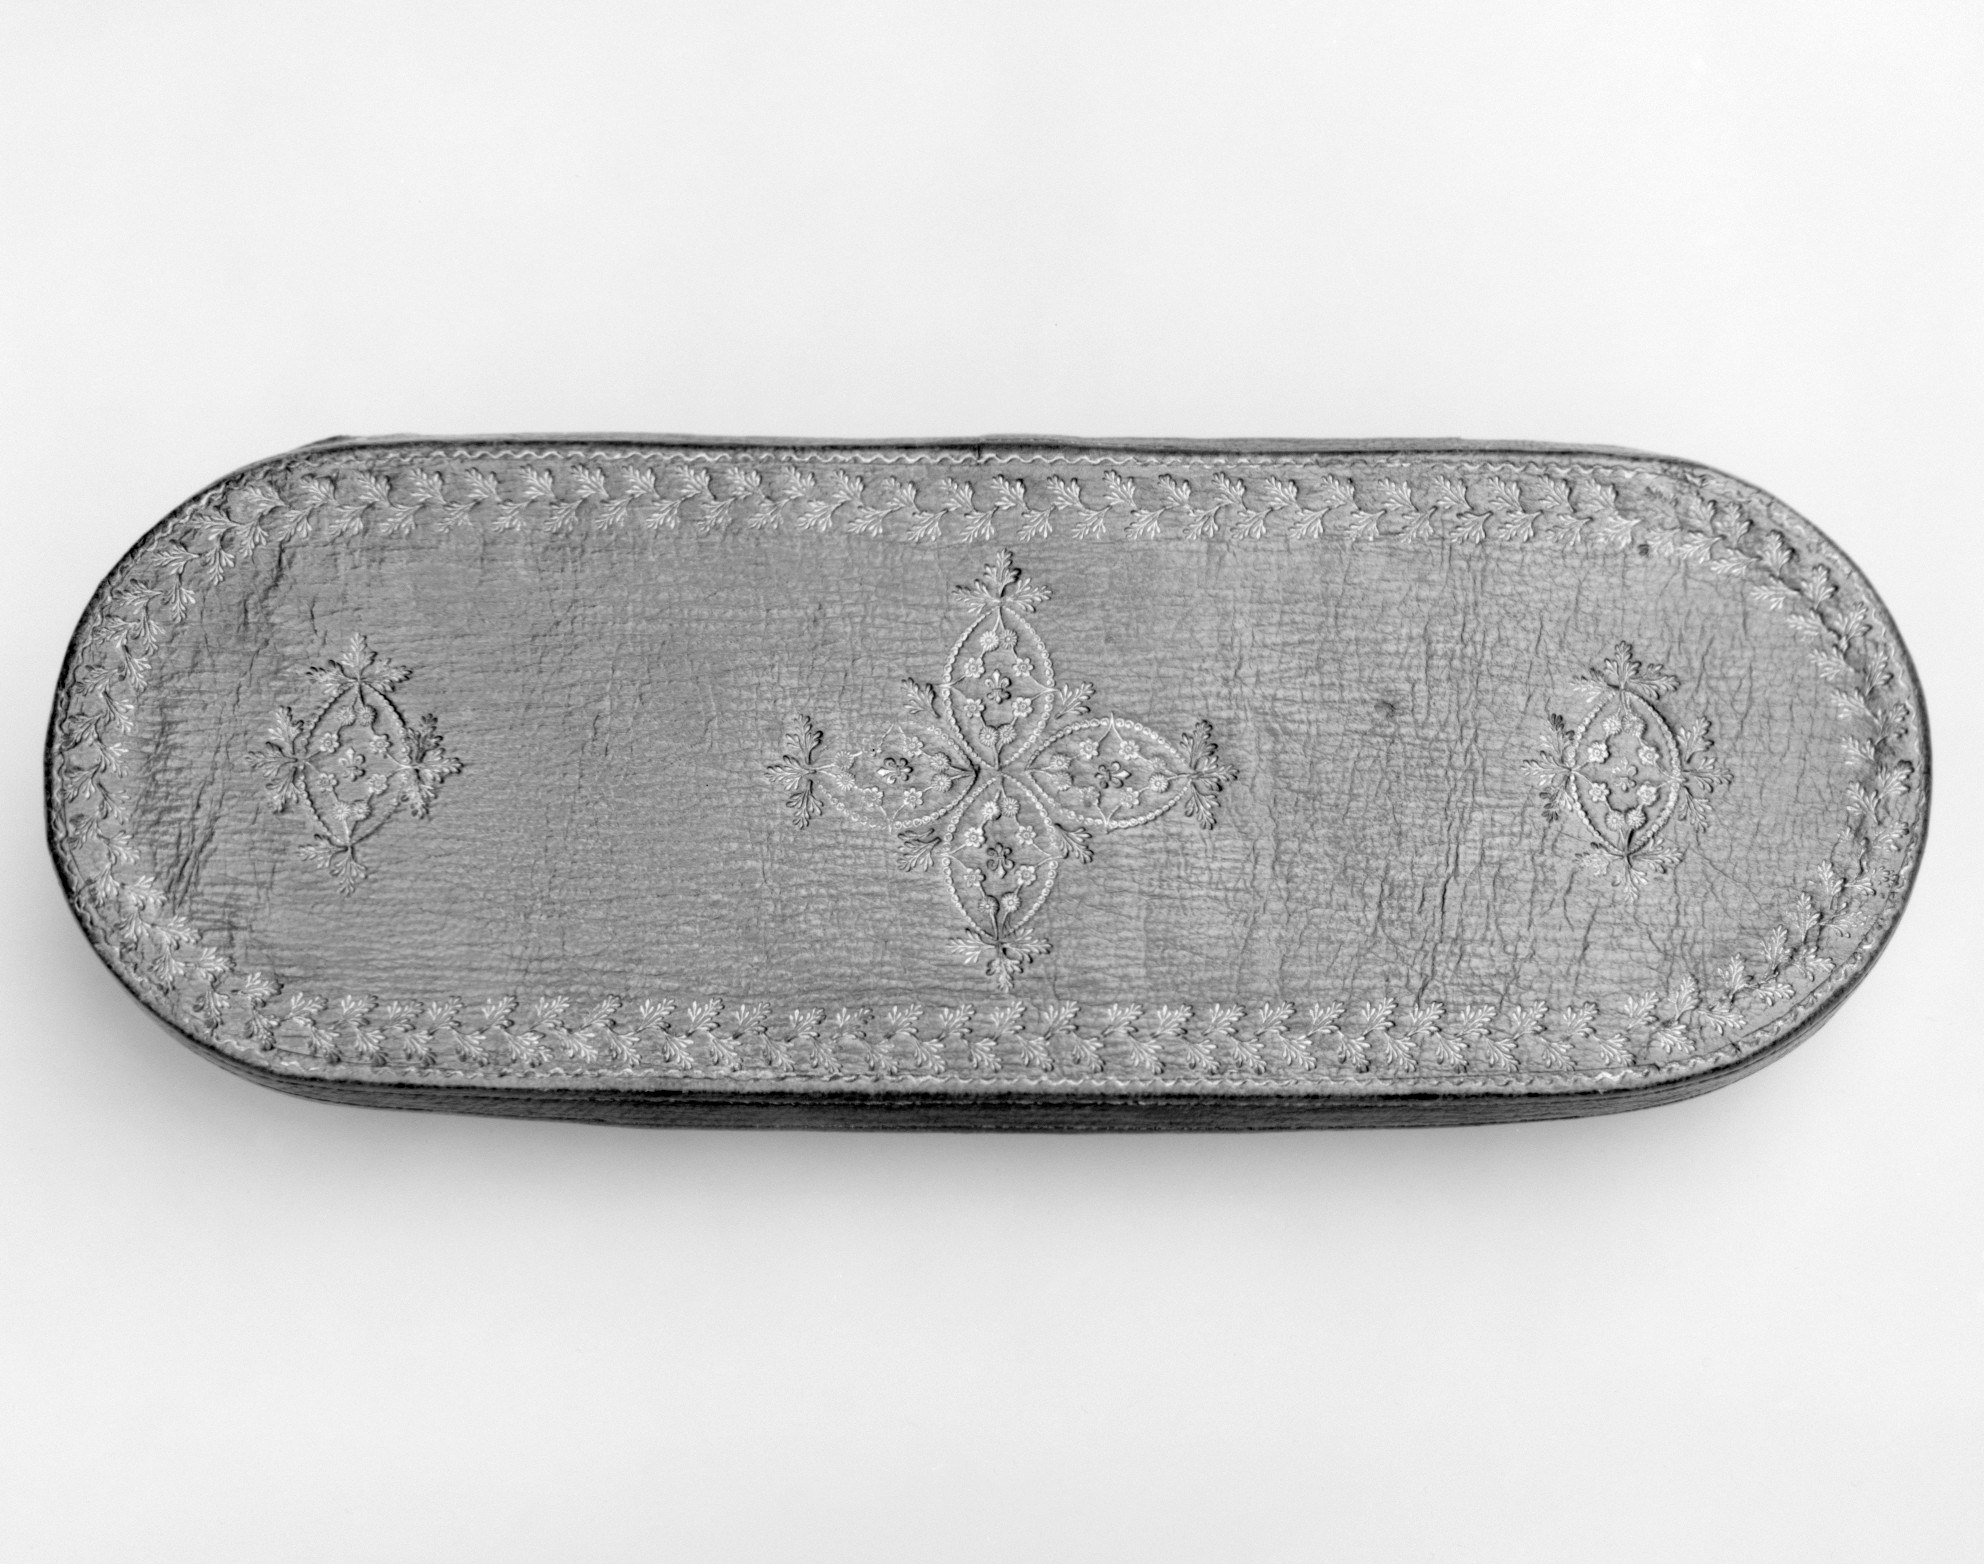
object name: case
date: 1760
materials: gilt, leather, paper